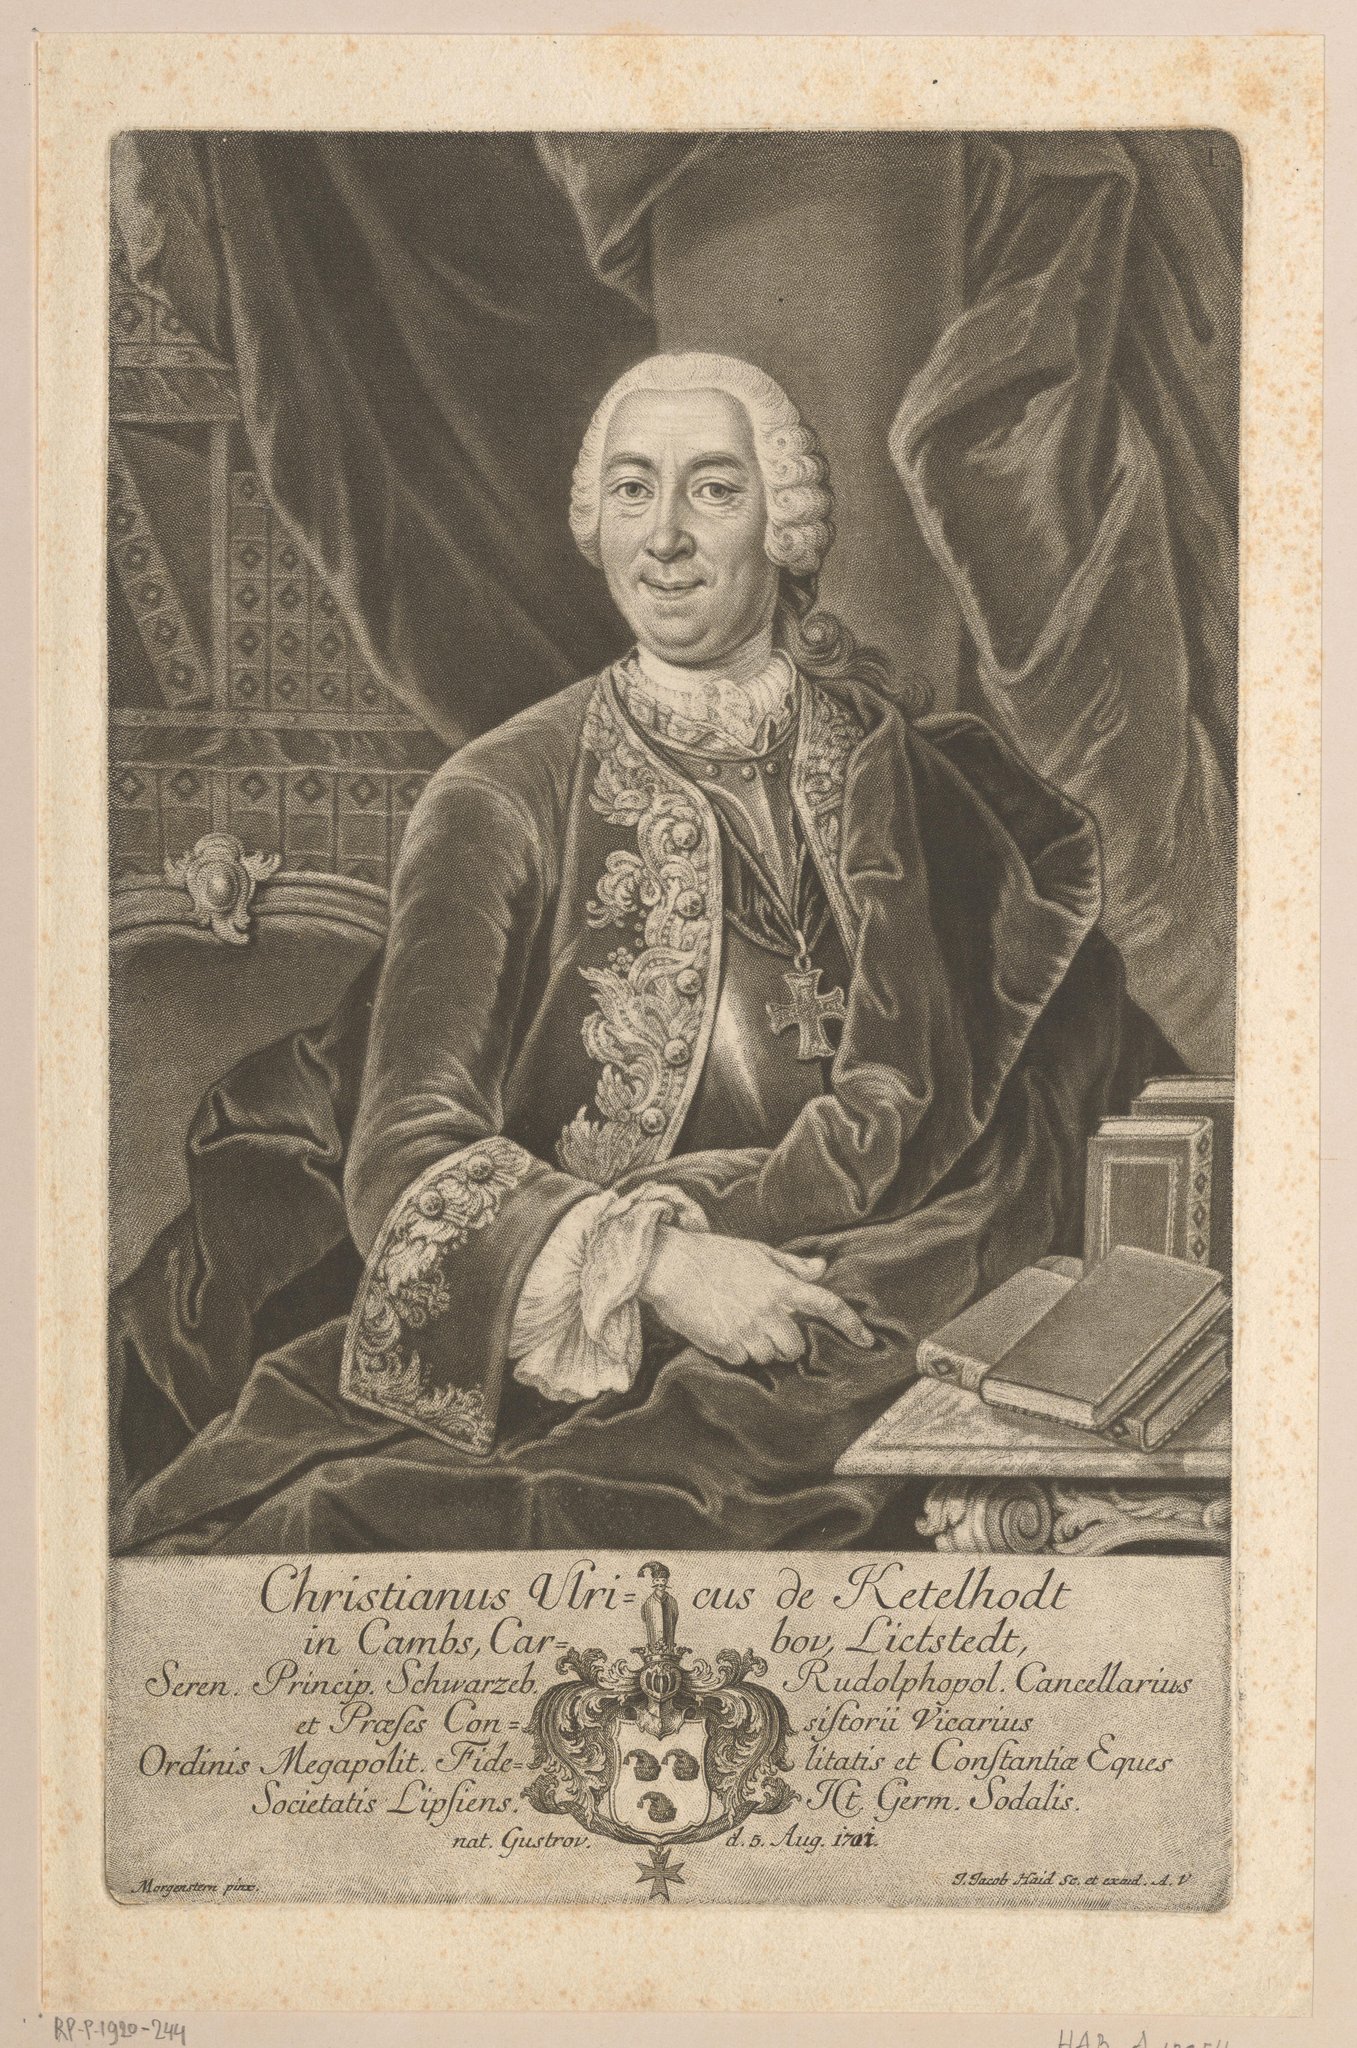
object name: print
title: Portret van Christian Ulrich von Ketelhodt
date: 1757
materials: paper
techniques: engraving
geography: augsburg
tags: bookshelves, historical persons, book, armorial bearing, heraldry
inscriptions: collector's mark: Lugt 2228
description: Prent mogelijk uit: Haid, Johann Jacob. Neue Sammlung von Bildnissen gelehrter. Augsburg: Johann Jacob Haid, 1757.